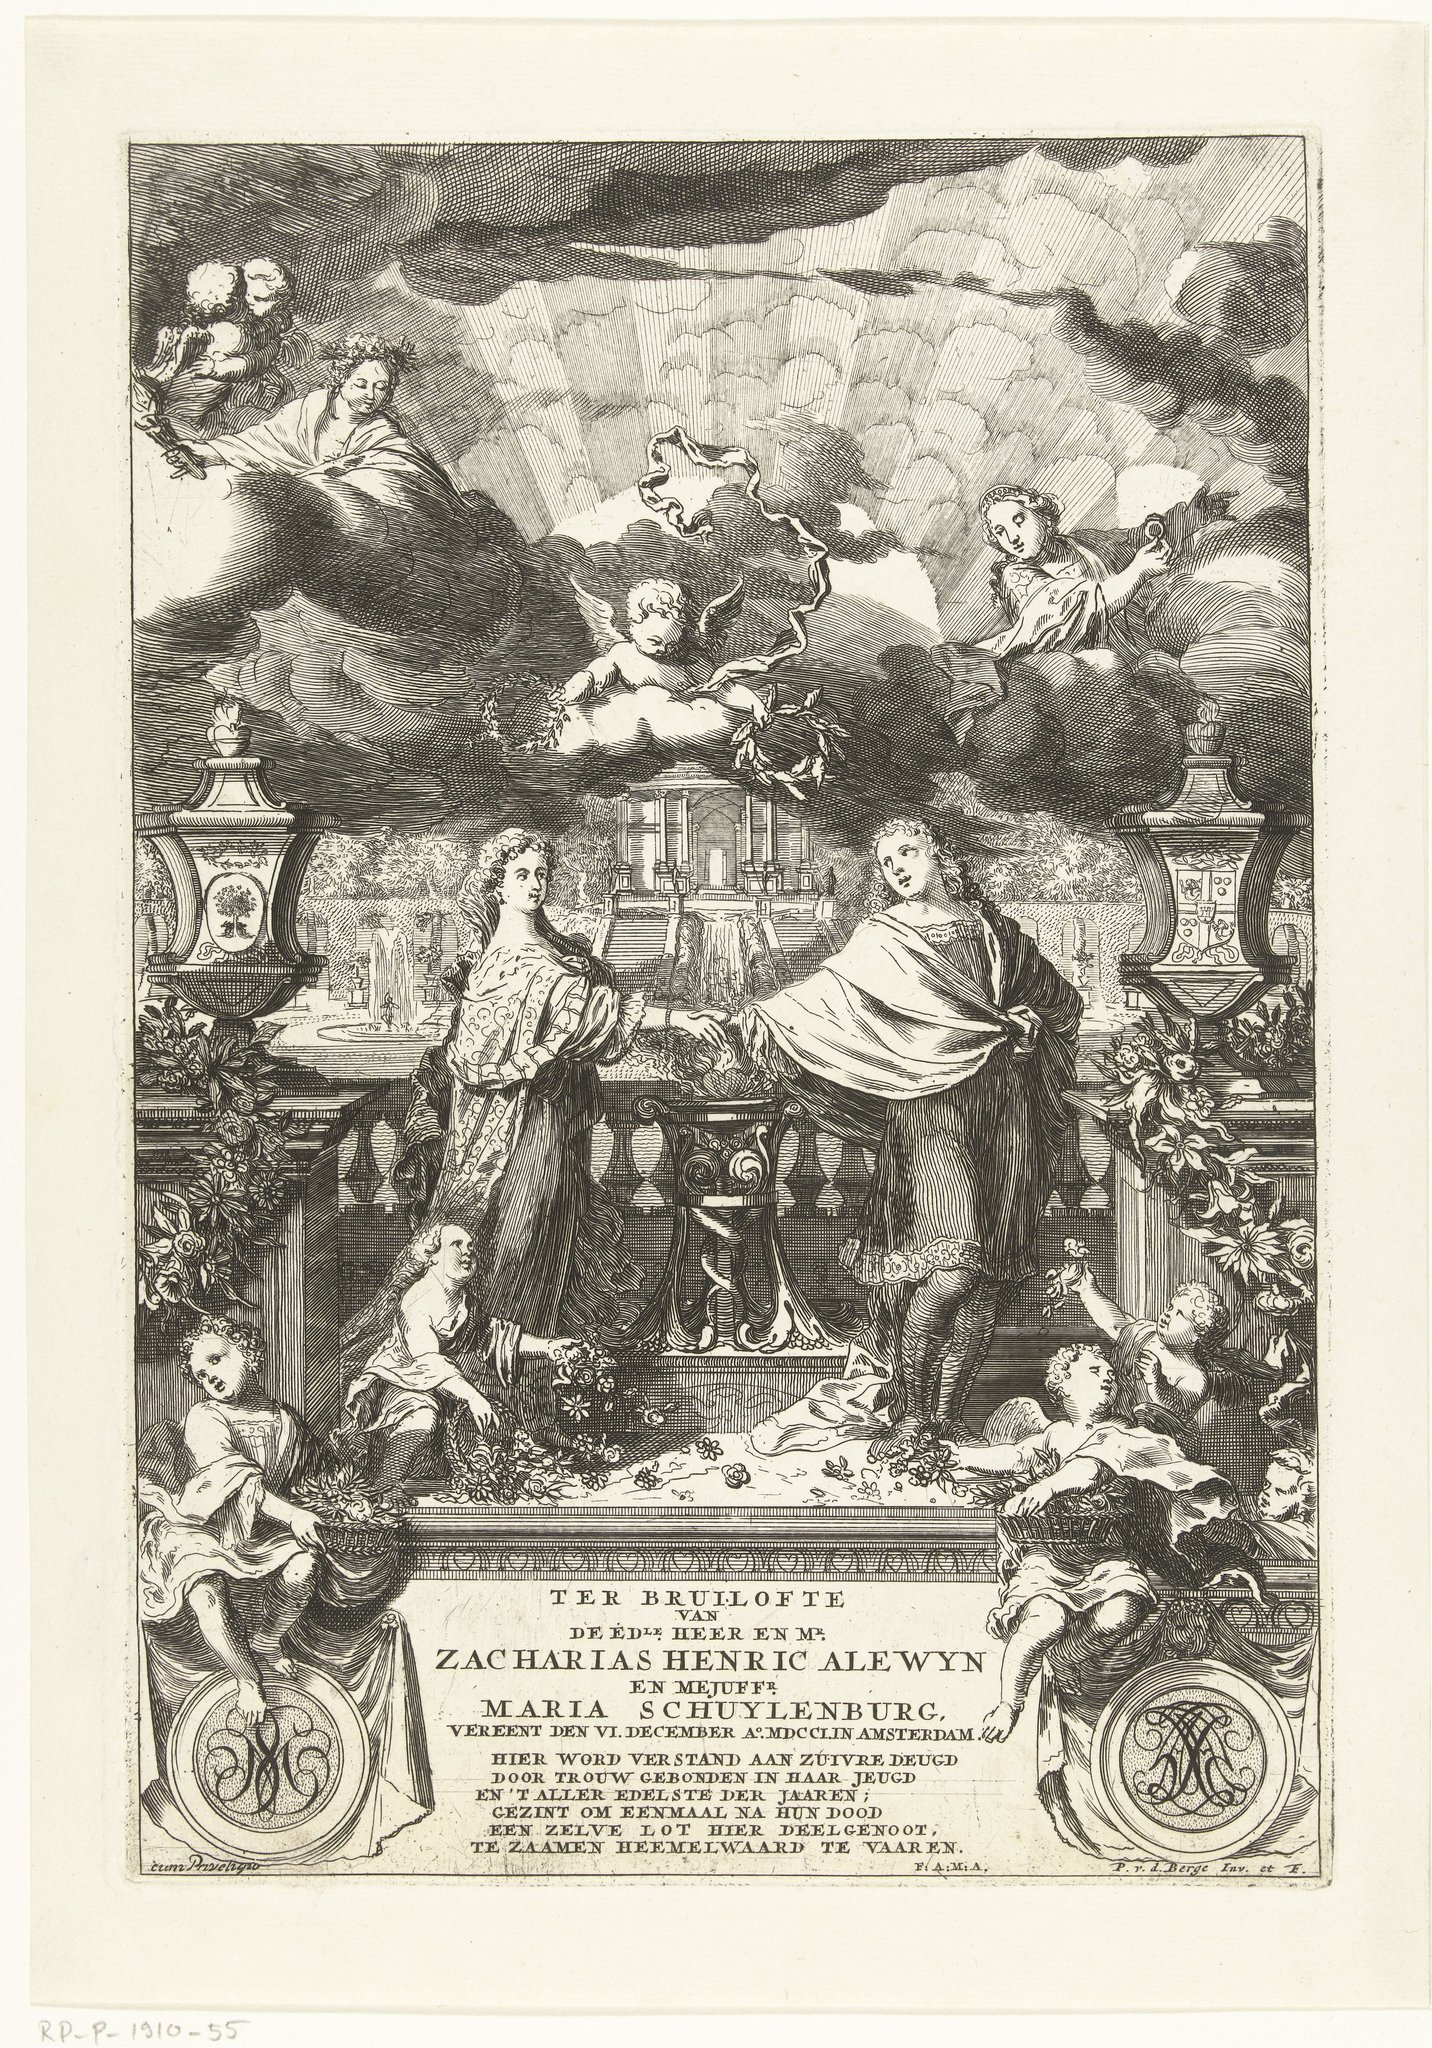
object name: print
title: Bruiloftsprent op het huwelijk van Zacharias Hendrik Alewijn en Maria Schuylenburgh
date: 1701-1703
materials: paper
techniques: engraving, etching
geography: amsterdam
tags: civil marriage ceremony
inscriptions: collector's mark: Lugt 2228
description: De bruid en bruidegom staan in een barokke tuin en houden elkaars hand vast. Kinderen en engelen strooien bloemen. Op een sokkel een vers van zes regels over het huwelijk.